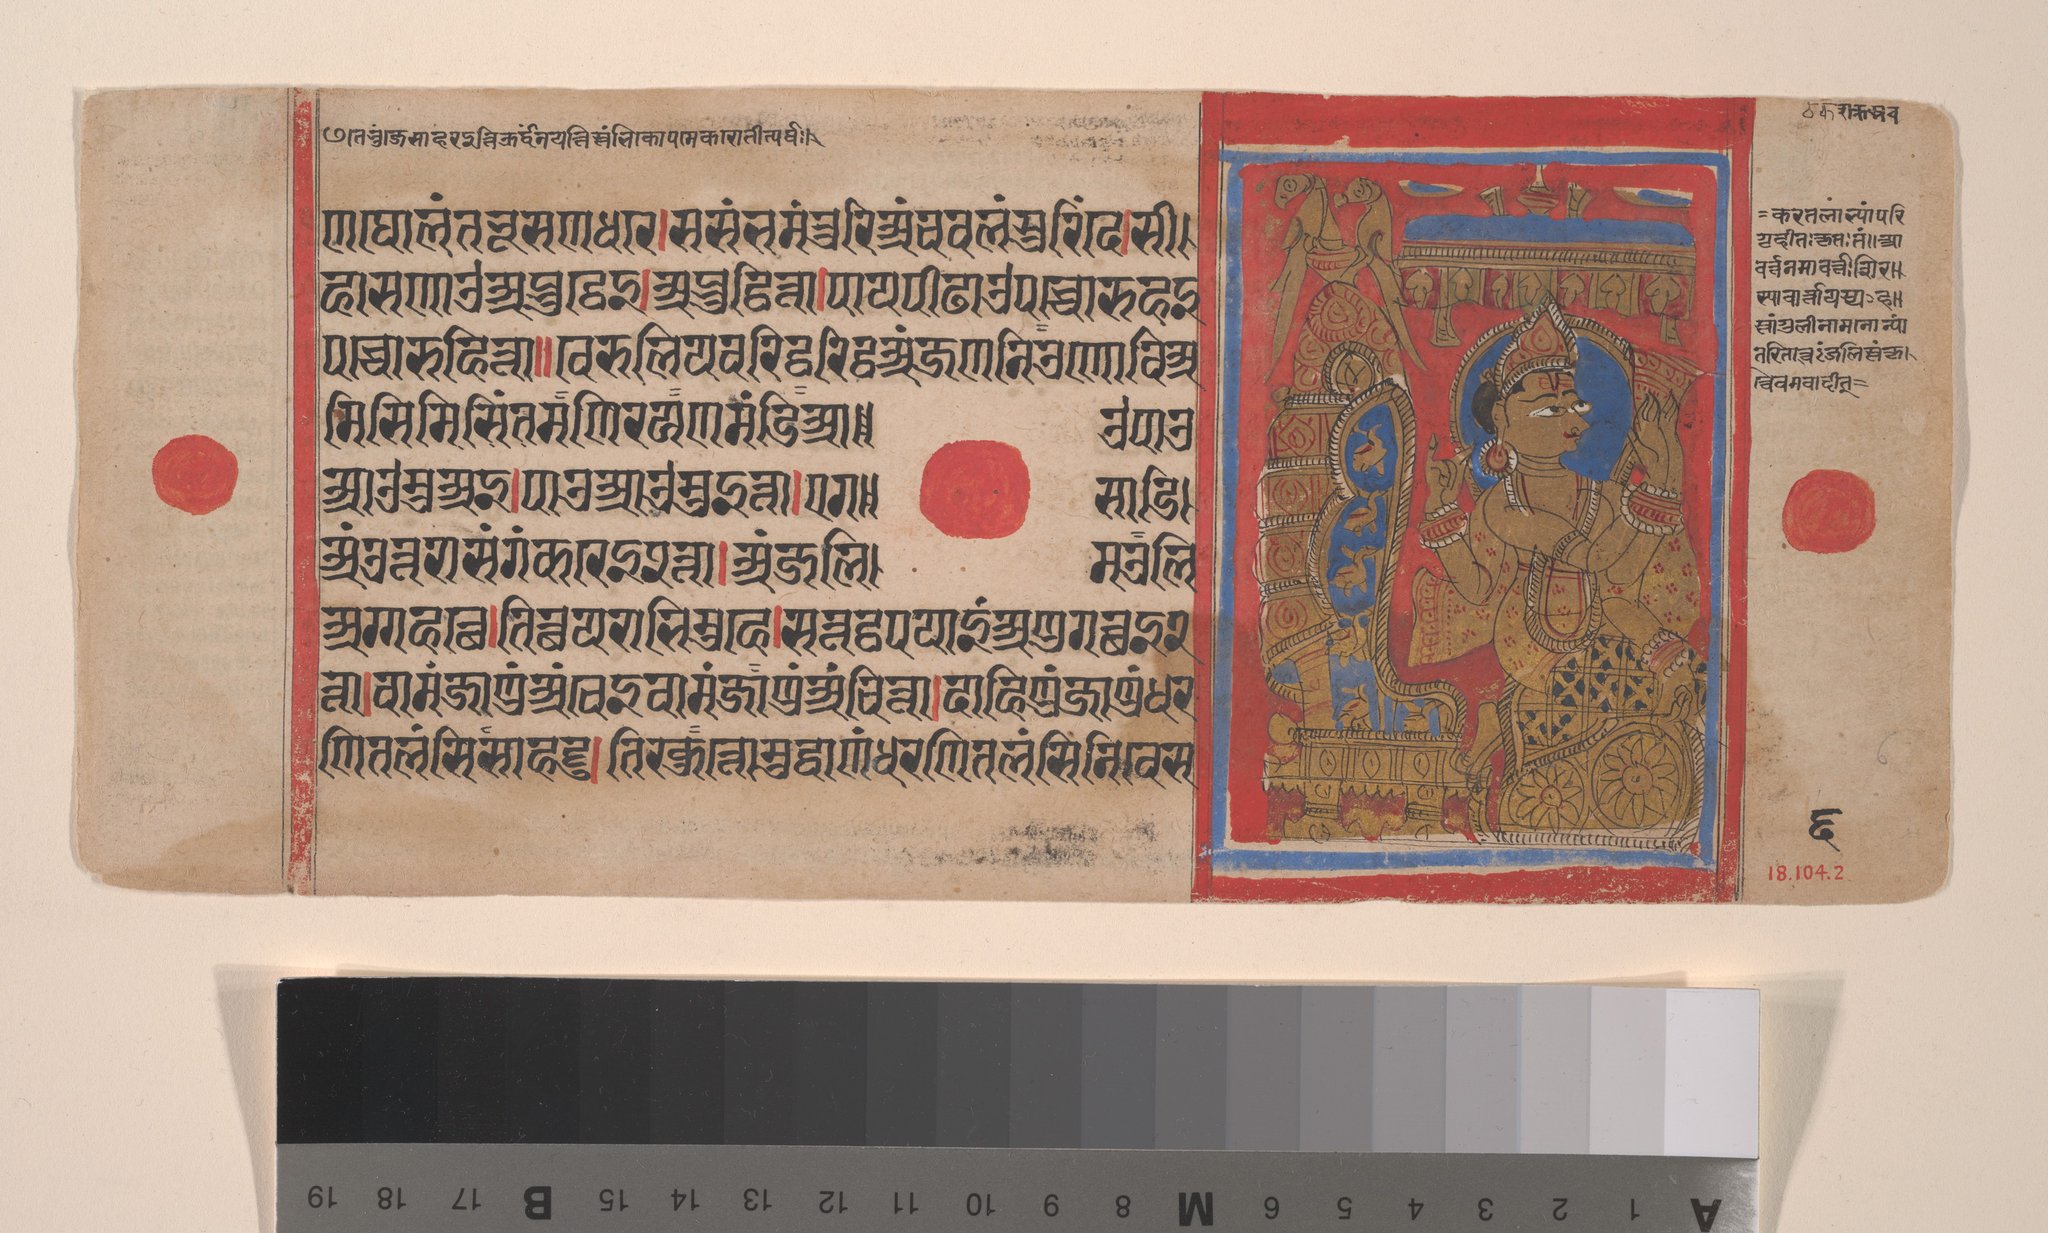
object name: manuscript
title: Indra Reverences Mahavira's Embryo: Folio from a Kalpasutra Manuscript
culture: indian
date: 1461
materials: gold, ink, paper, watercolor